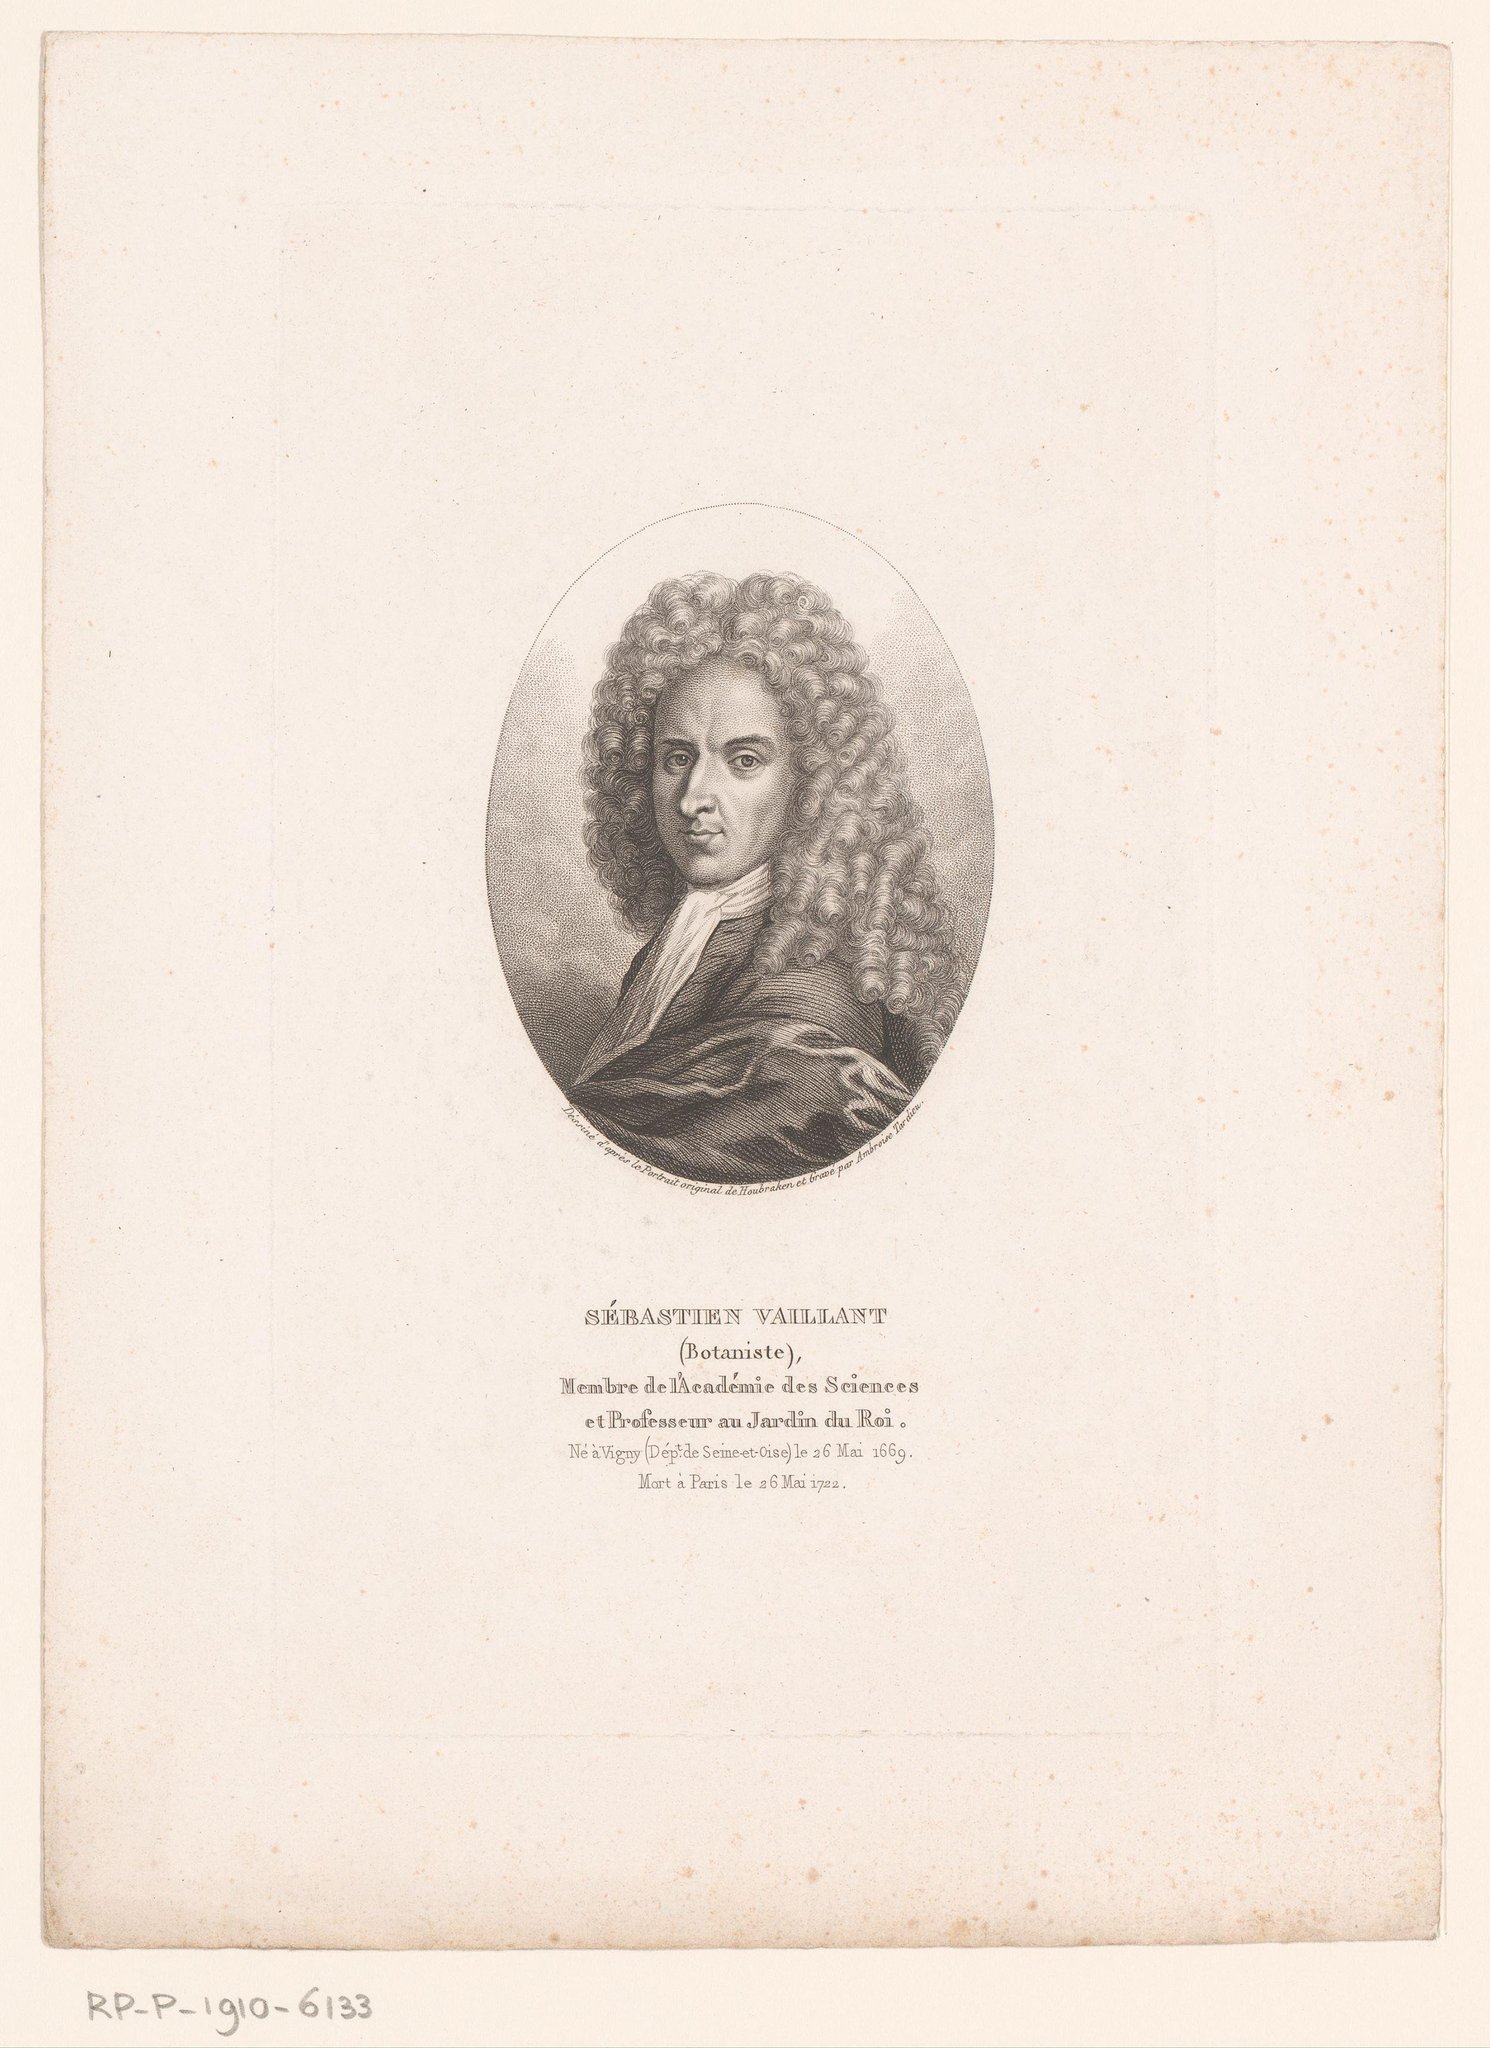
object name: print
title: Collection de tous les personnages célèbres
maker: ambroise tardieu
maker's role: print maker, printer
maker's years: 1788-1841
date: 1820-1828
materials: paper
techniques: engraving, roulette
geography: paris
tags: historical persons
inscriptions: collector's mark: Lugt 2228